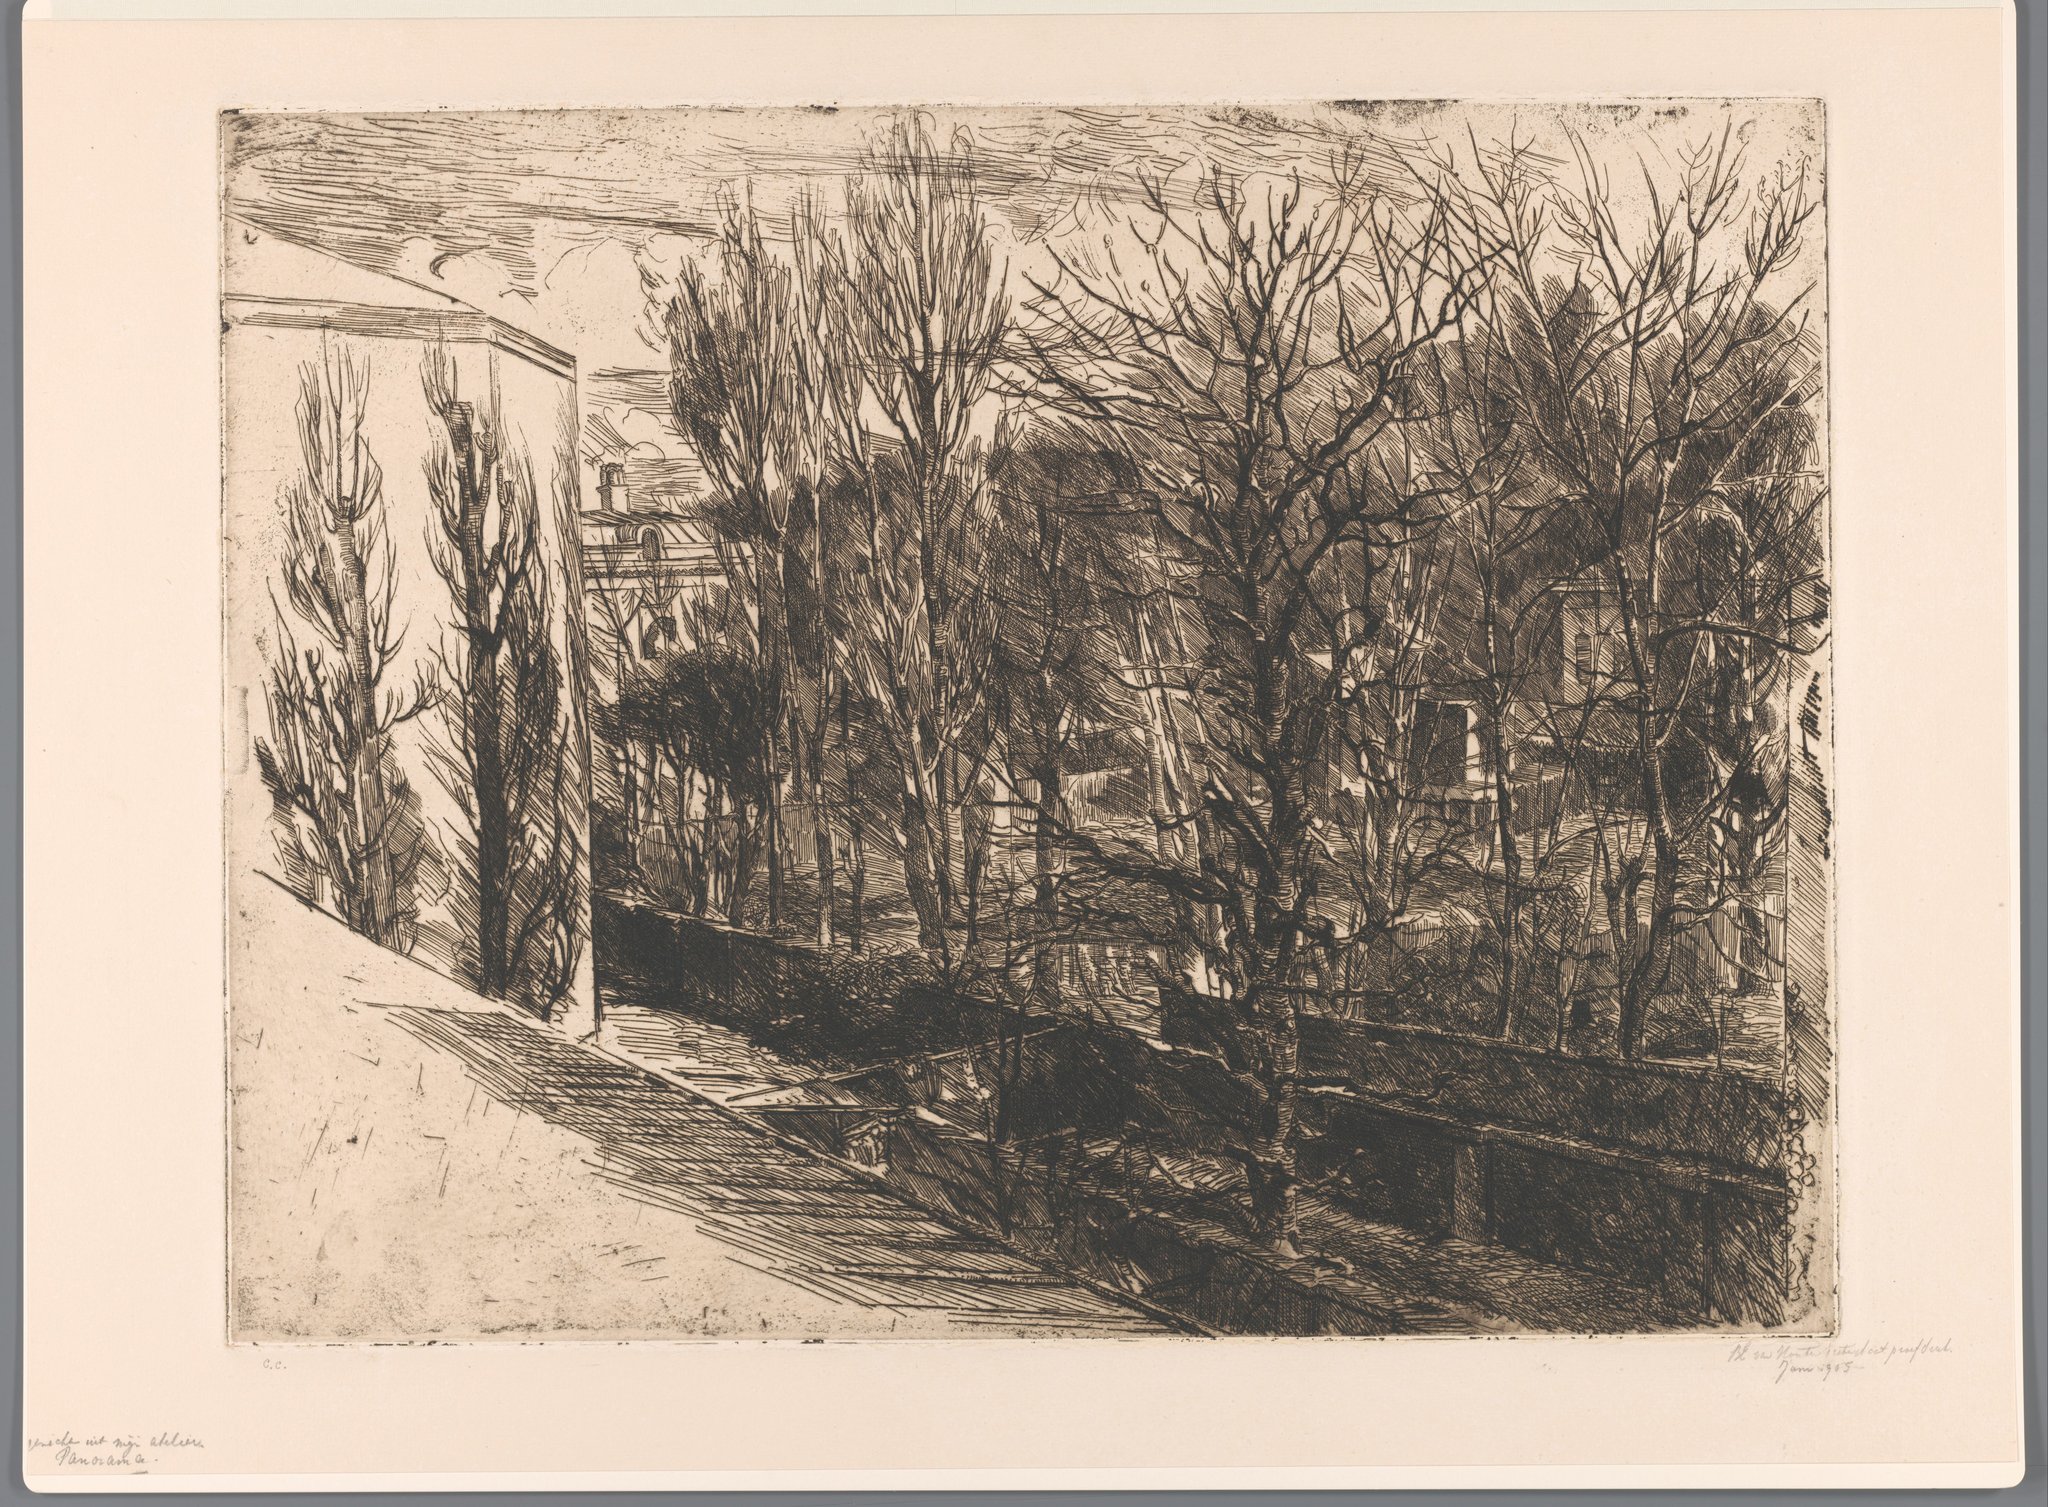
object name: print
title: Panorama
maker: barbara elisabeth van houten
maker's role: draughtsman, print maker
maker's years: 1862-1950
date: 1905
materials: paper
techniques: etching, intaglio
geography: the hague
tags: view through a window, garden, workshop, studio ~ painter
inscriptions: collector's mark: Lugt 2228, inscription: ‘C.C./ [...] J'ami’